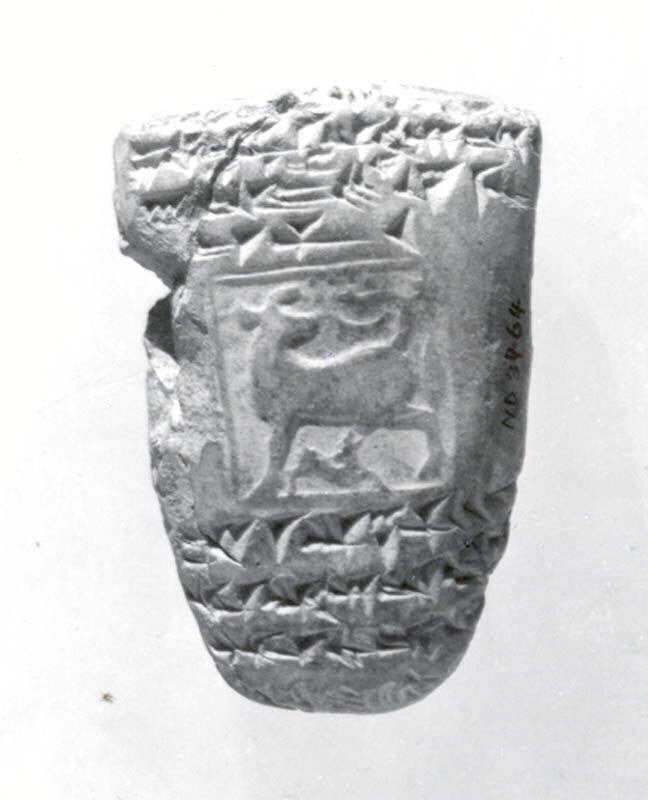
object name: cuneiform tablet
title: Triangular label impressed with stamp seal: for grain loan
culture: assyrian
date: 700-601 BCE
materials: clay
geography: mesopotamia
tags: animals